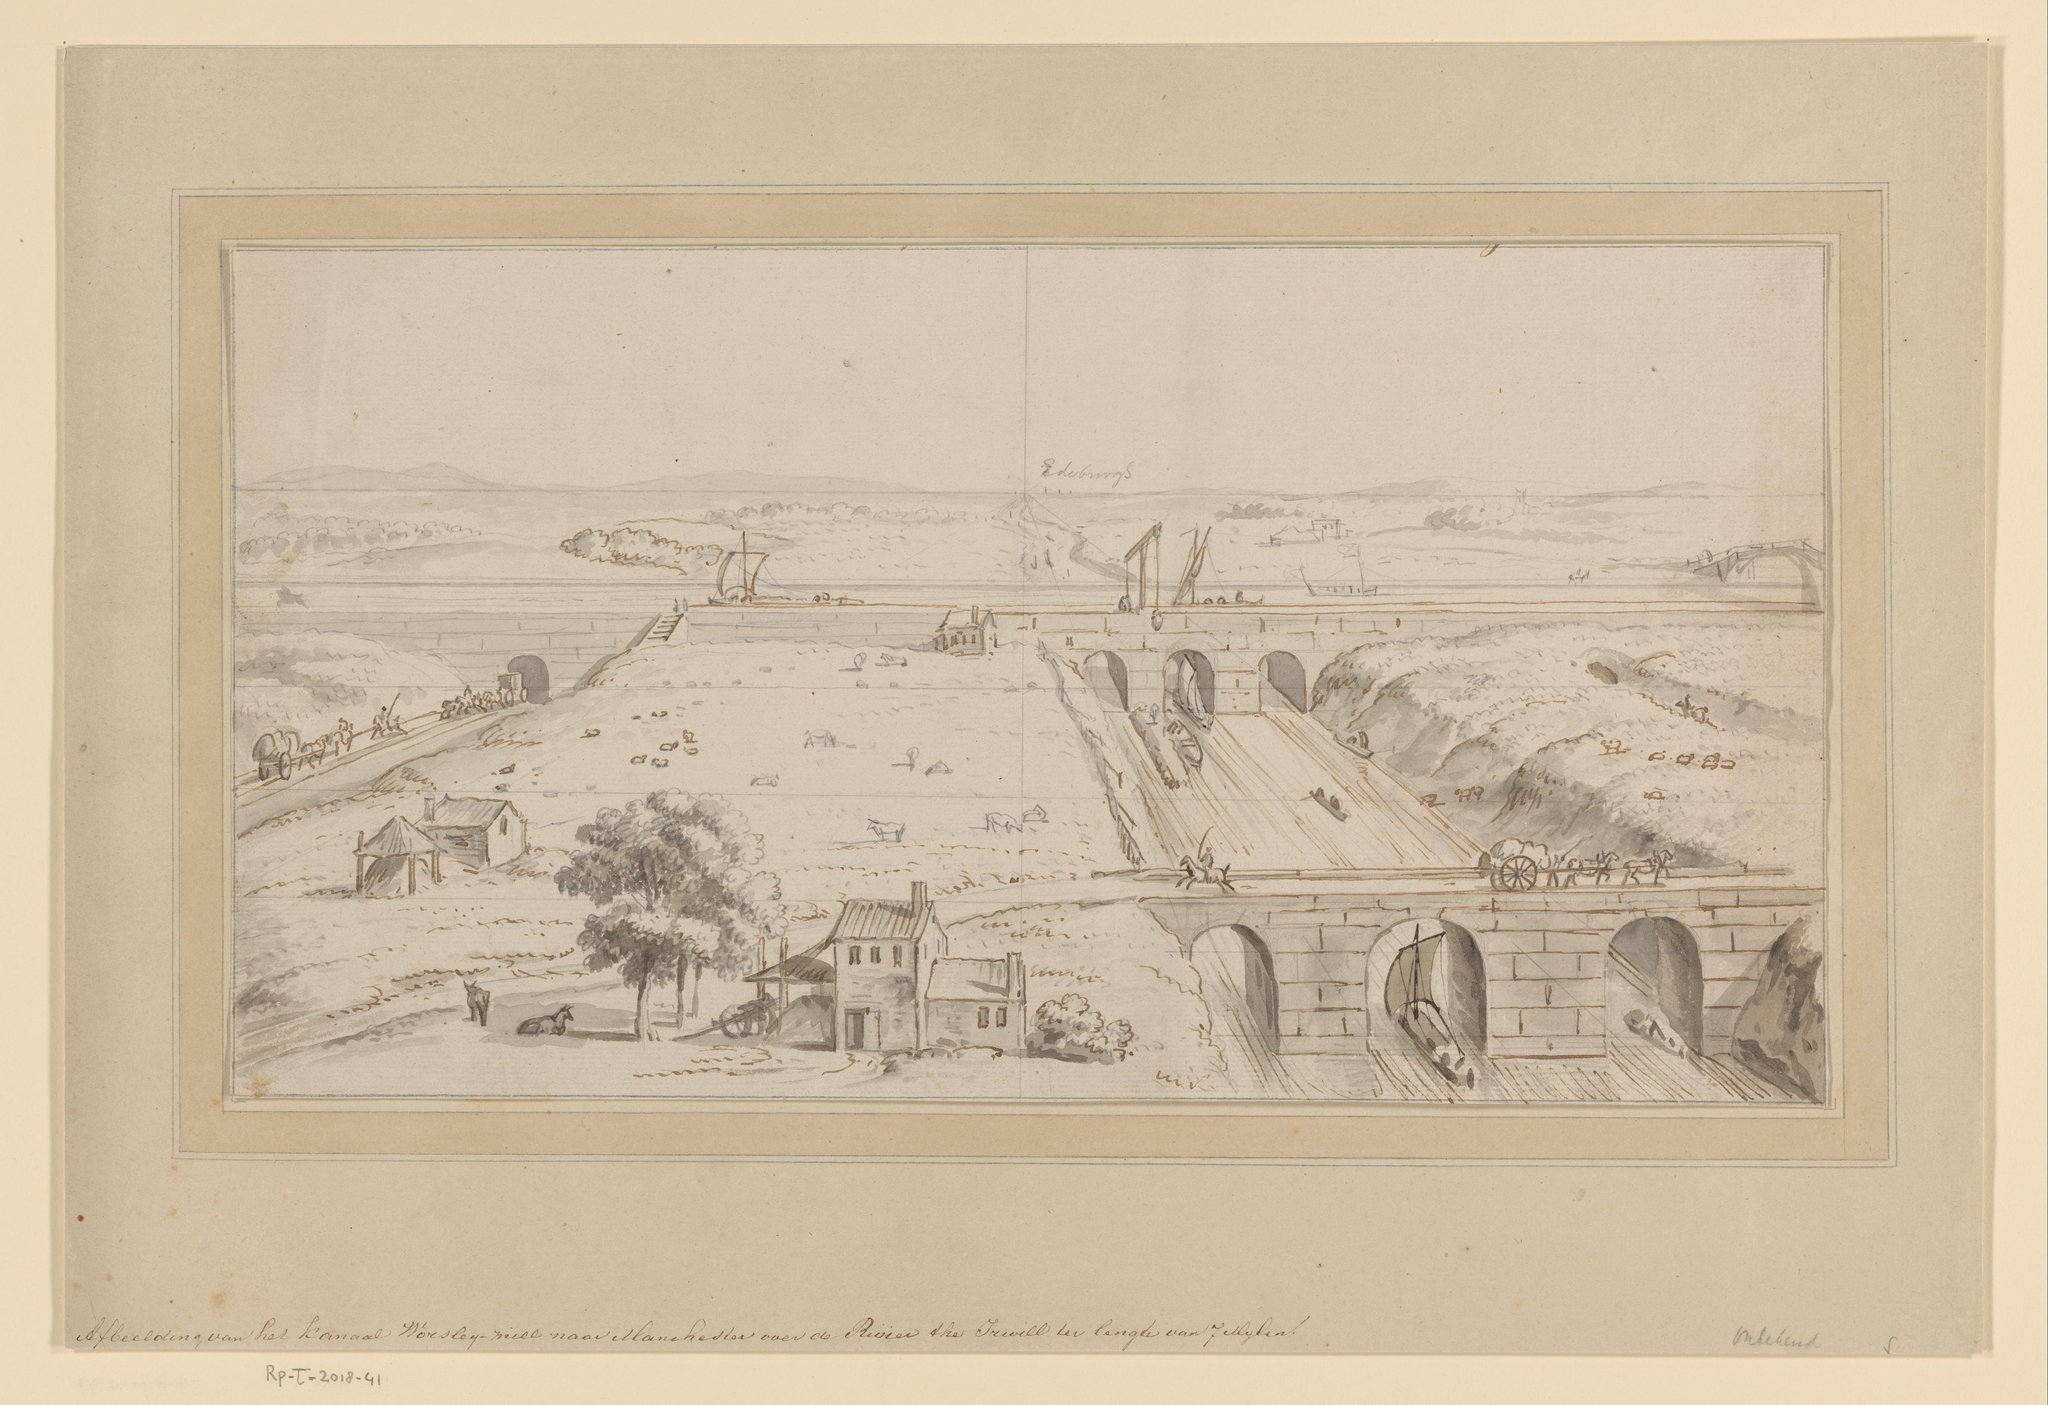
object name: drawing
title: Gezicht op een landschap met een brug en een kanaal over een rivier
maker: Anonymous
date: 1700-1800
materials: ink, paper, pencil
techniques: brush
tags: sailing-ship, sailing-boat, rowing-boat, canoe, etc., bridge, manchester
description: Mogelijk gezicht op het kanaal van Worsley Mill naar Manchester over de rivier de Irwell.